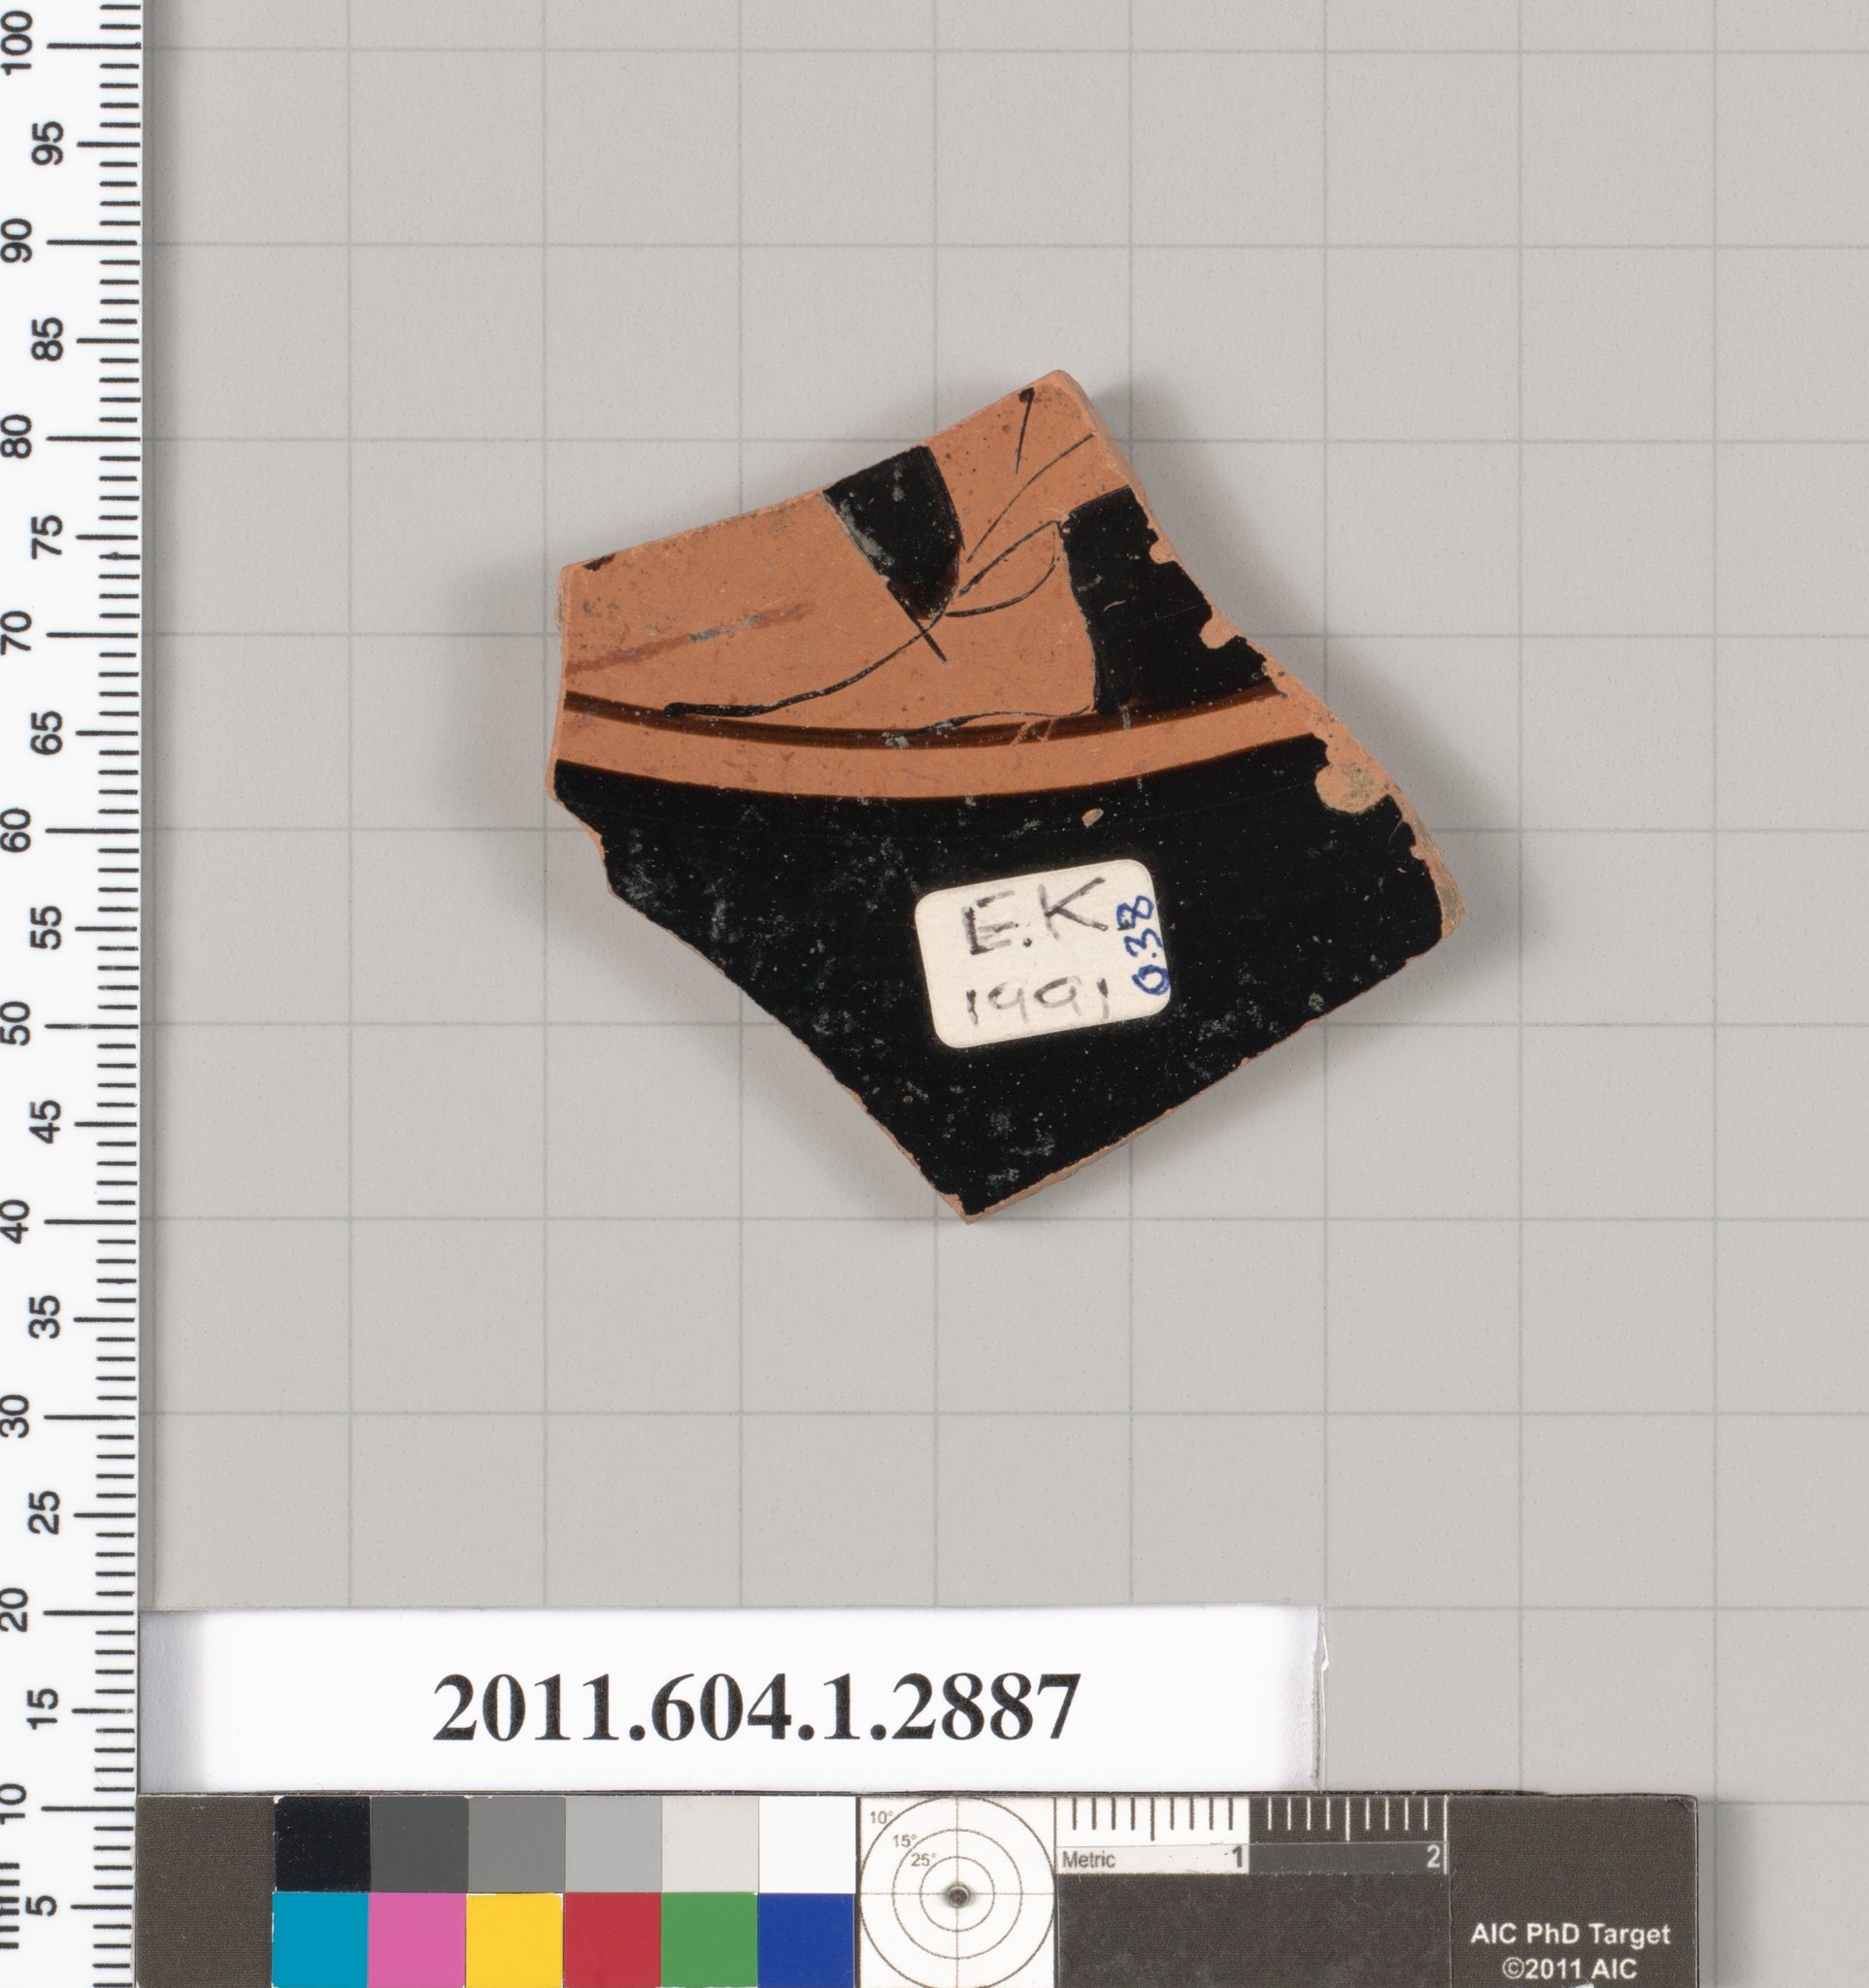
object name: kylix fragment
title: Terracotta fragment of a kylix (drinking cup)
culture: greek, attic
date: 475-451 BCE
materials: terracotta